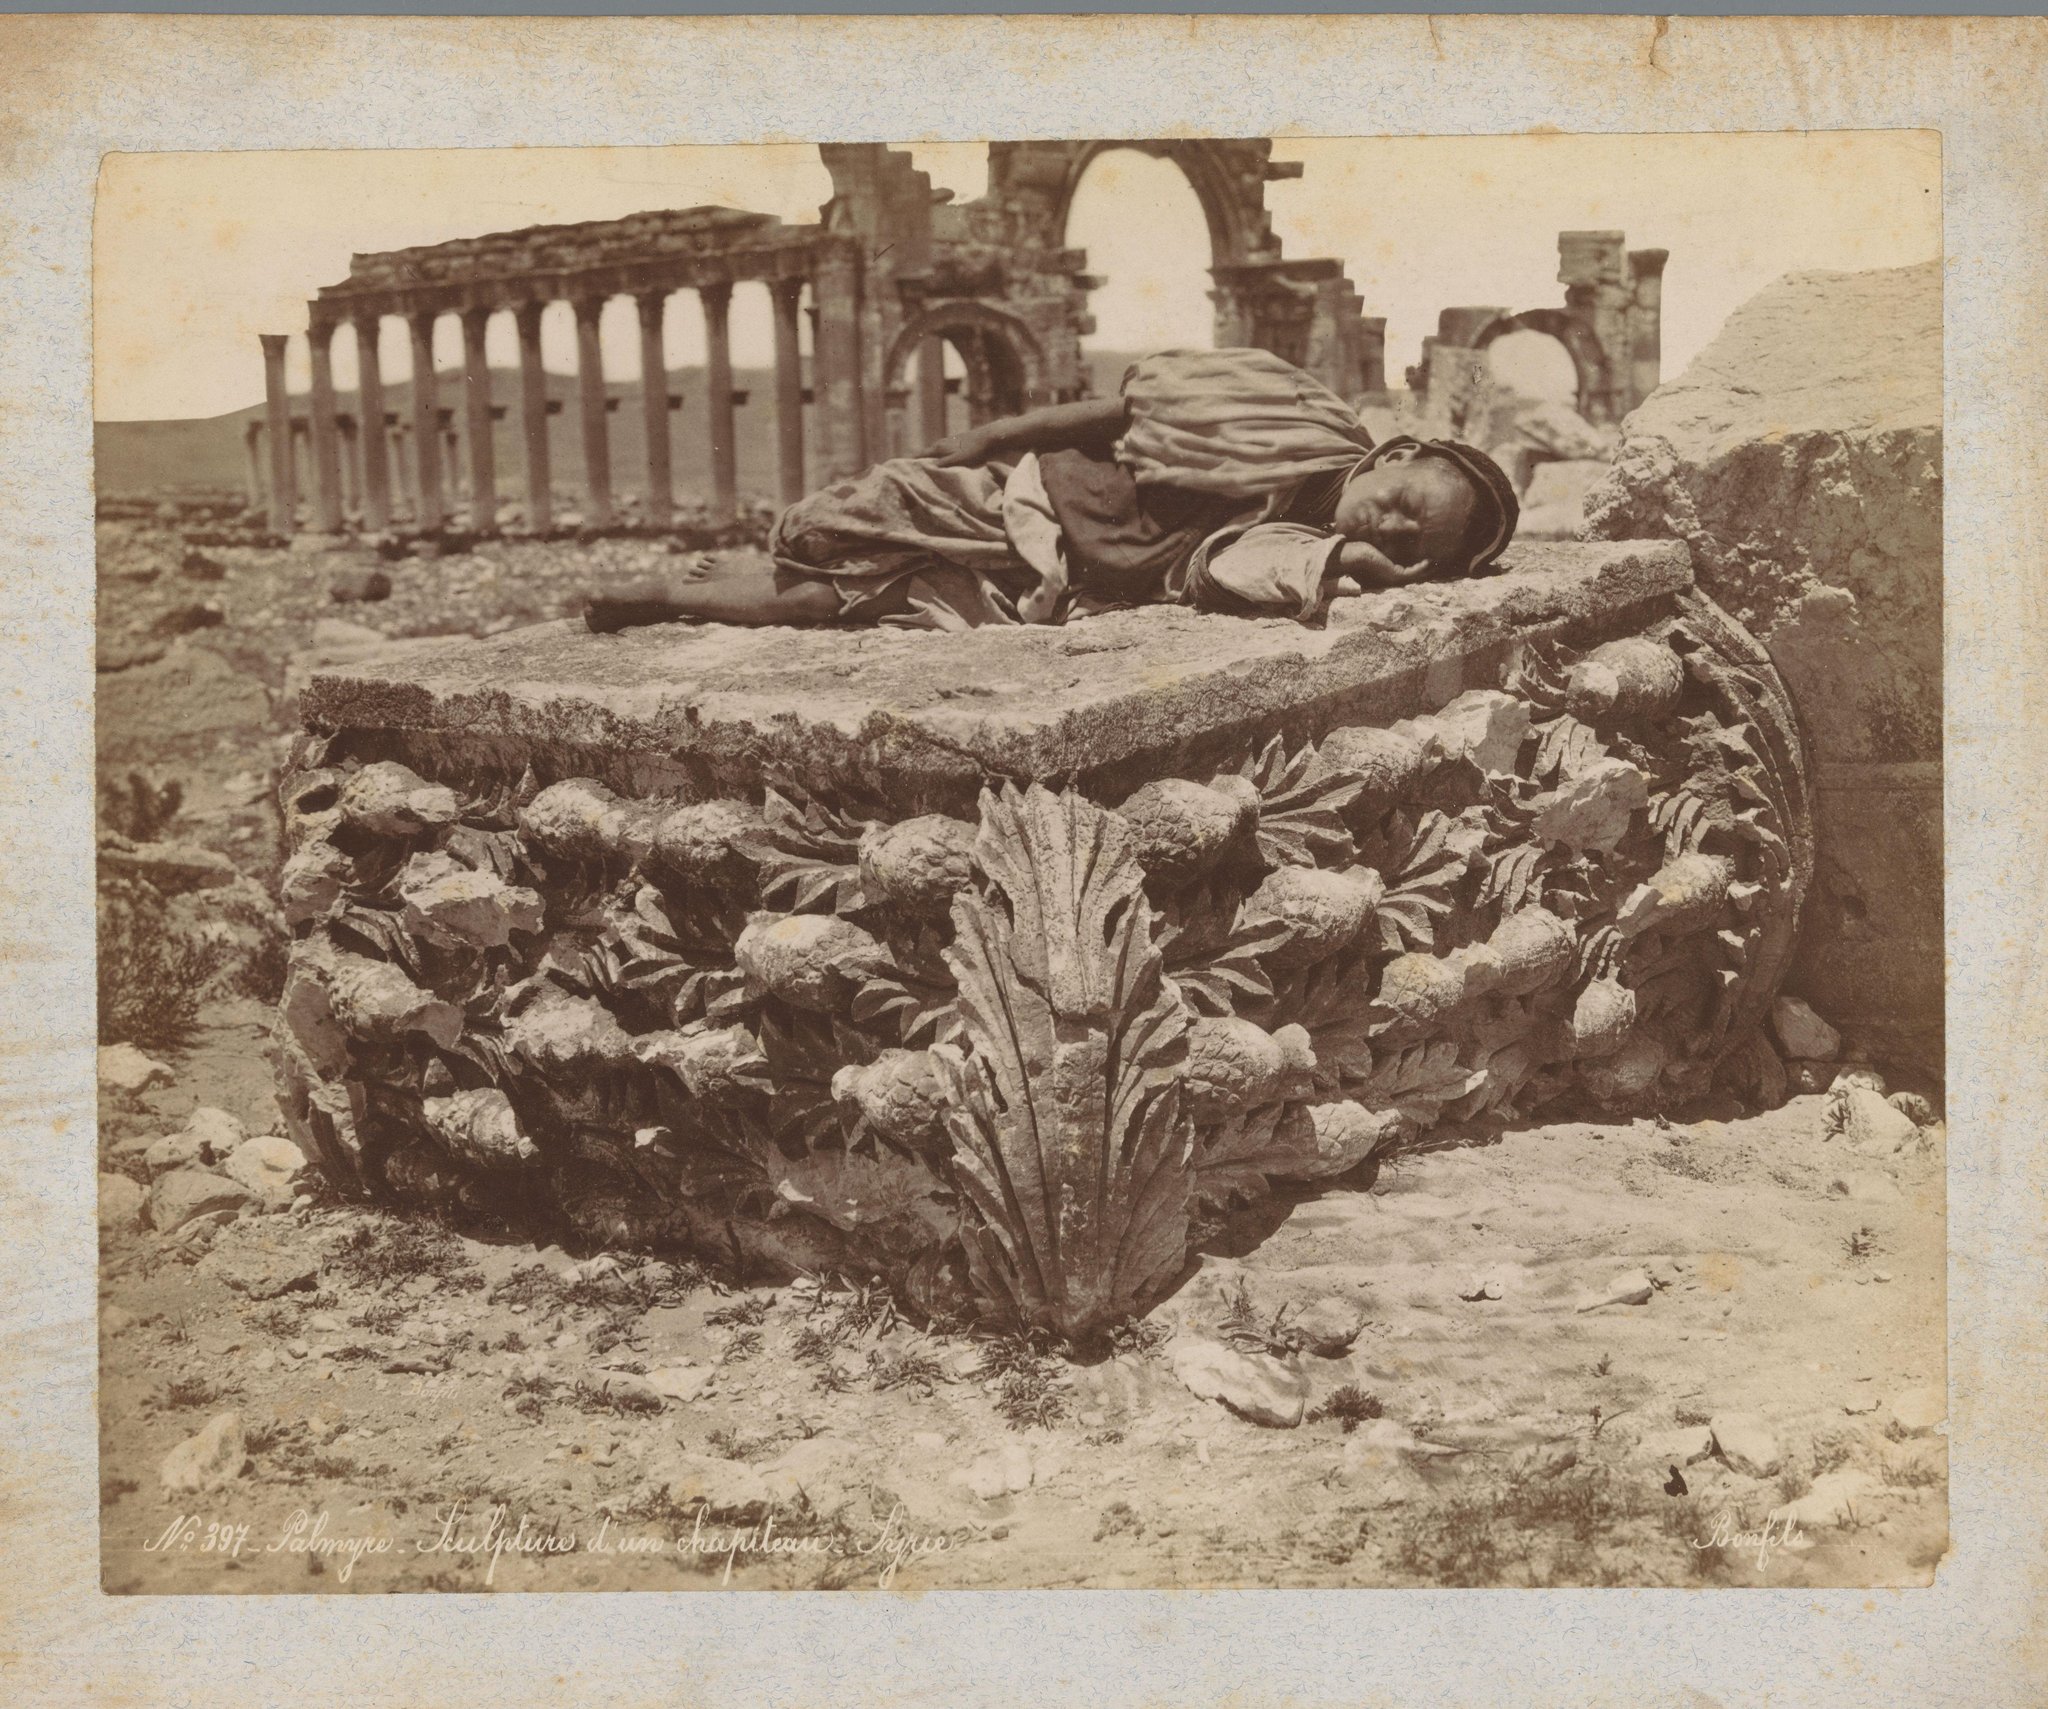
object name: photograph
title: Palmyre - Sculpture d'un chapiteau - Syrie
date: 1860-1900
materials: cardboard, photographic support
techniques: albumen print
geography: palmyra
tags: fruits: pineapple, landscape with ruins, capital (~ column, pillar), lying figure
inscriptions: collector's mark: Lugt 3937, number: ‘No 397’, inscription: ‘fl. 6 IV’